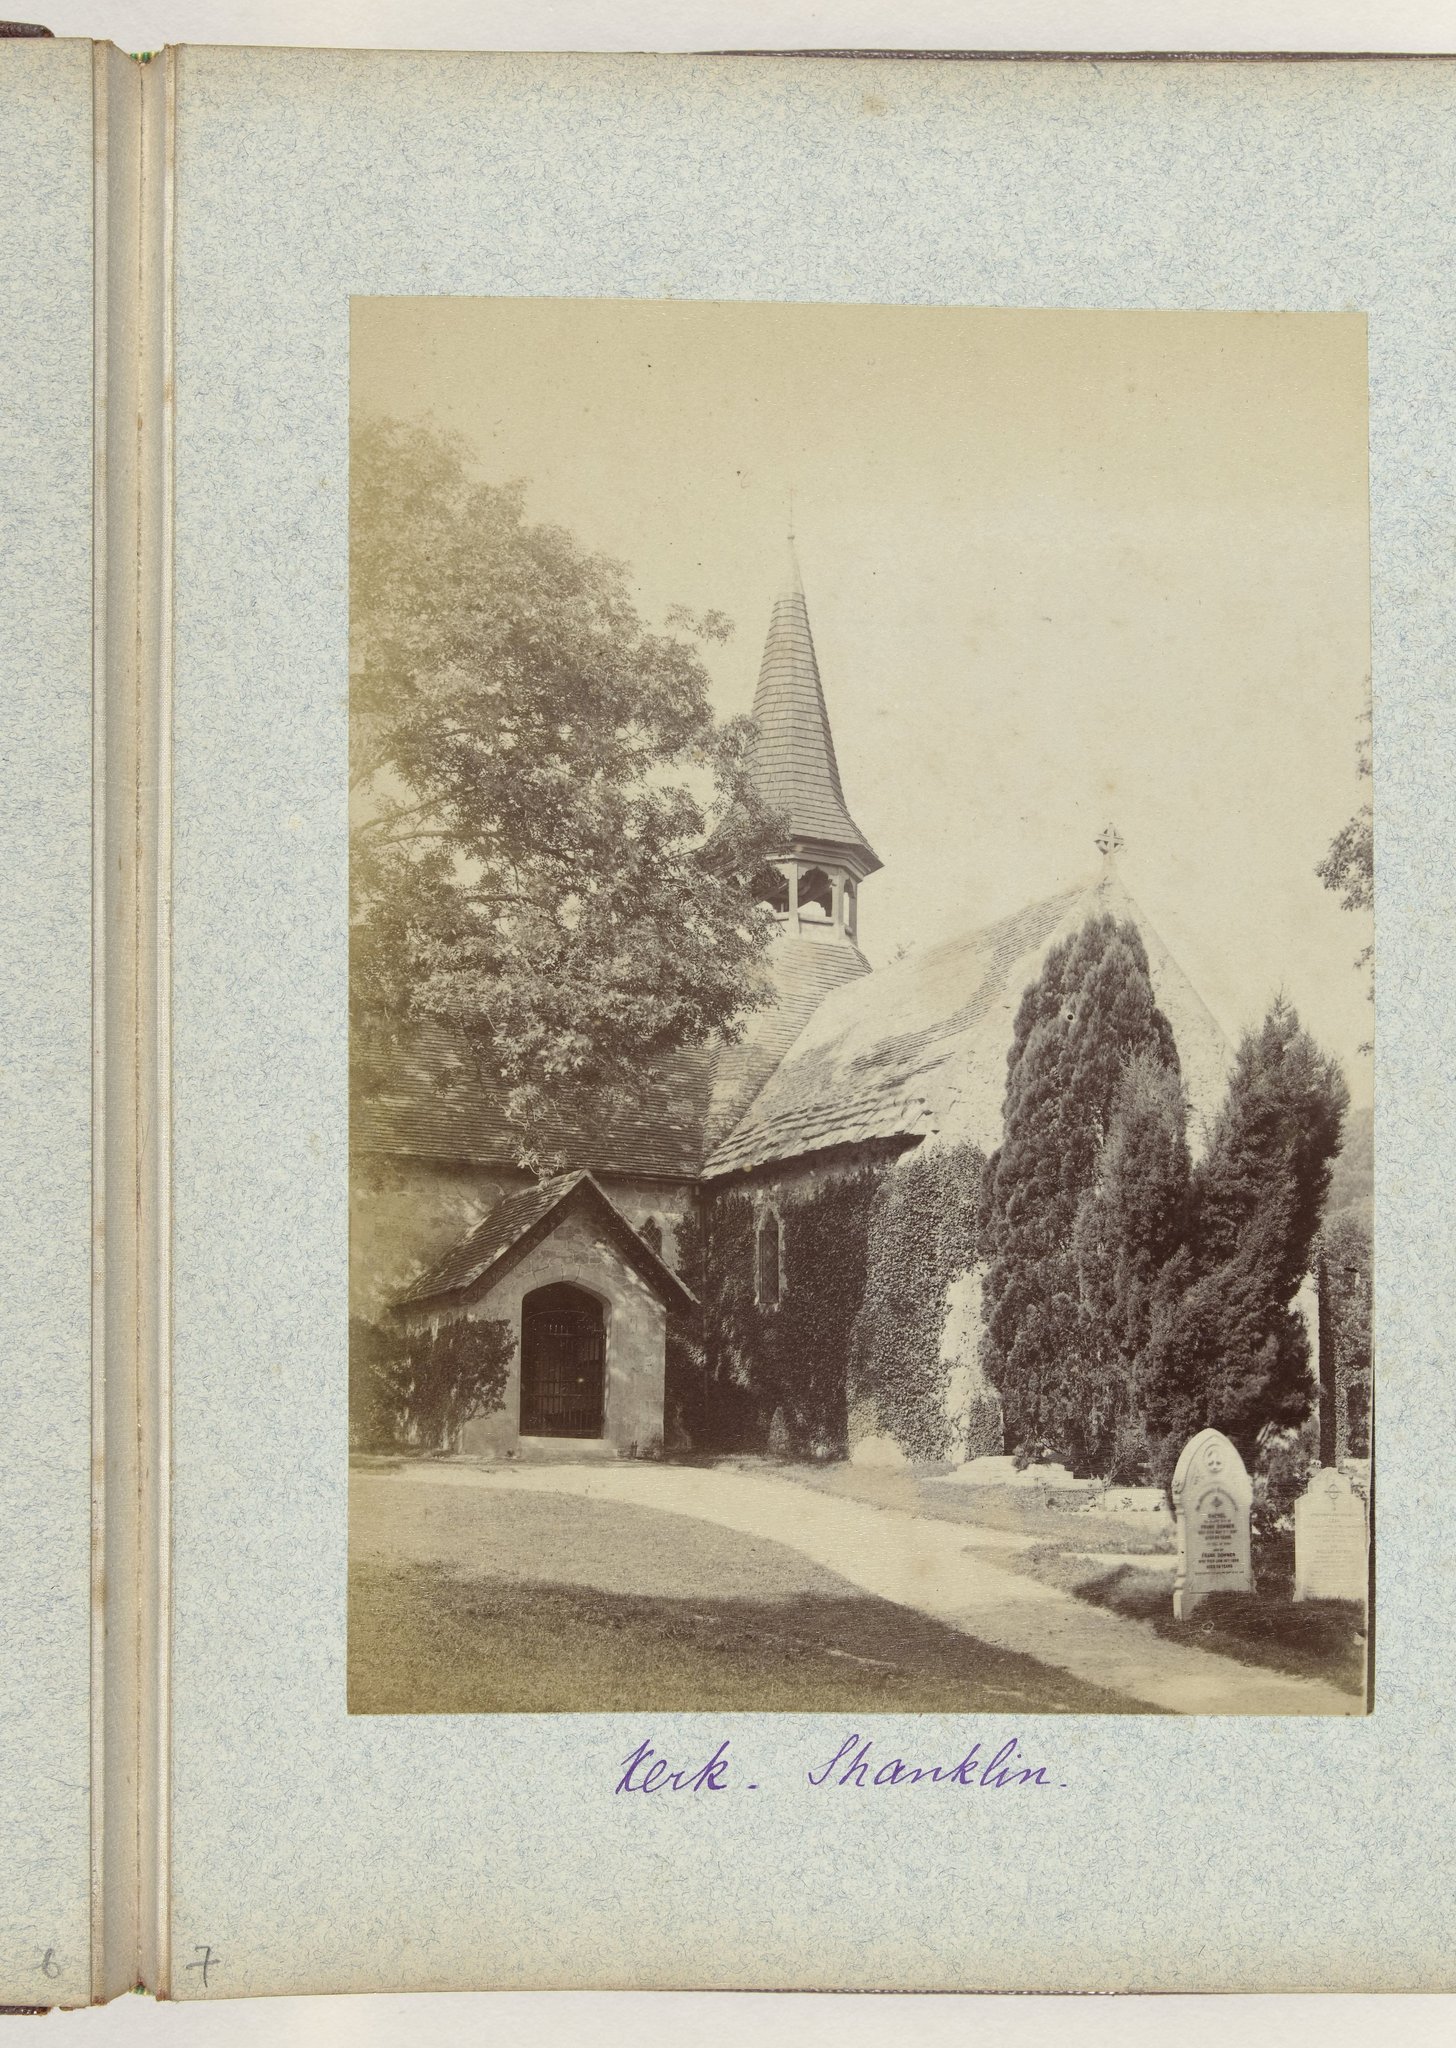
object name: photograph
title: Saint Blasius Church te Shanklin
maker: henry pauw van wieldrecht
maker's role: fotograaf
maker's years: 1863-1912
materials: cardboard, paper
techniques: albumen print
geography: shanklin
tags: church (exterior)